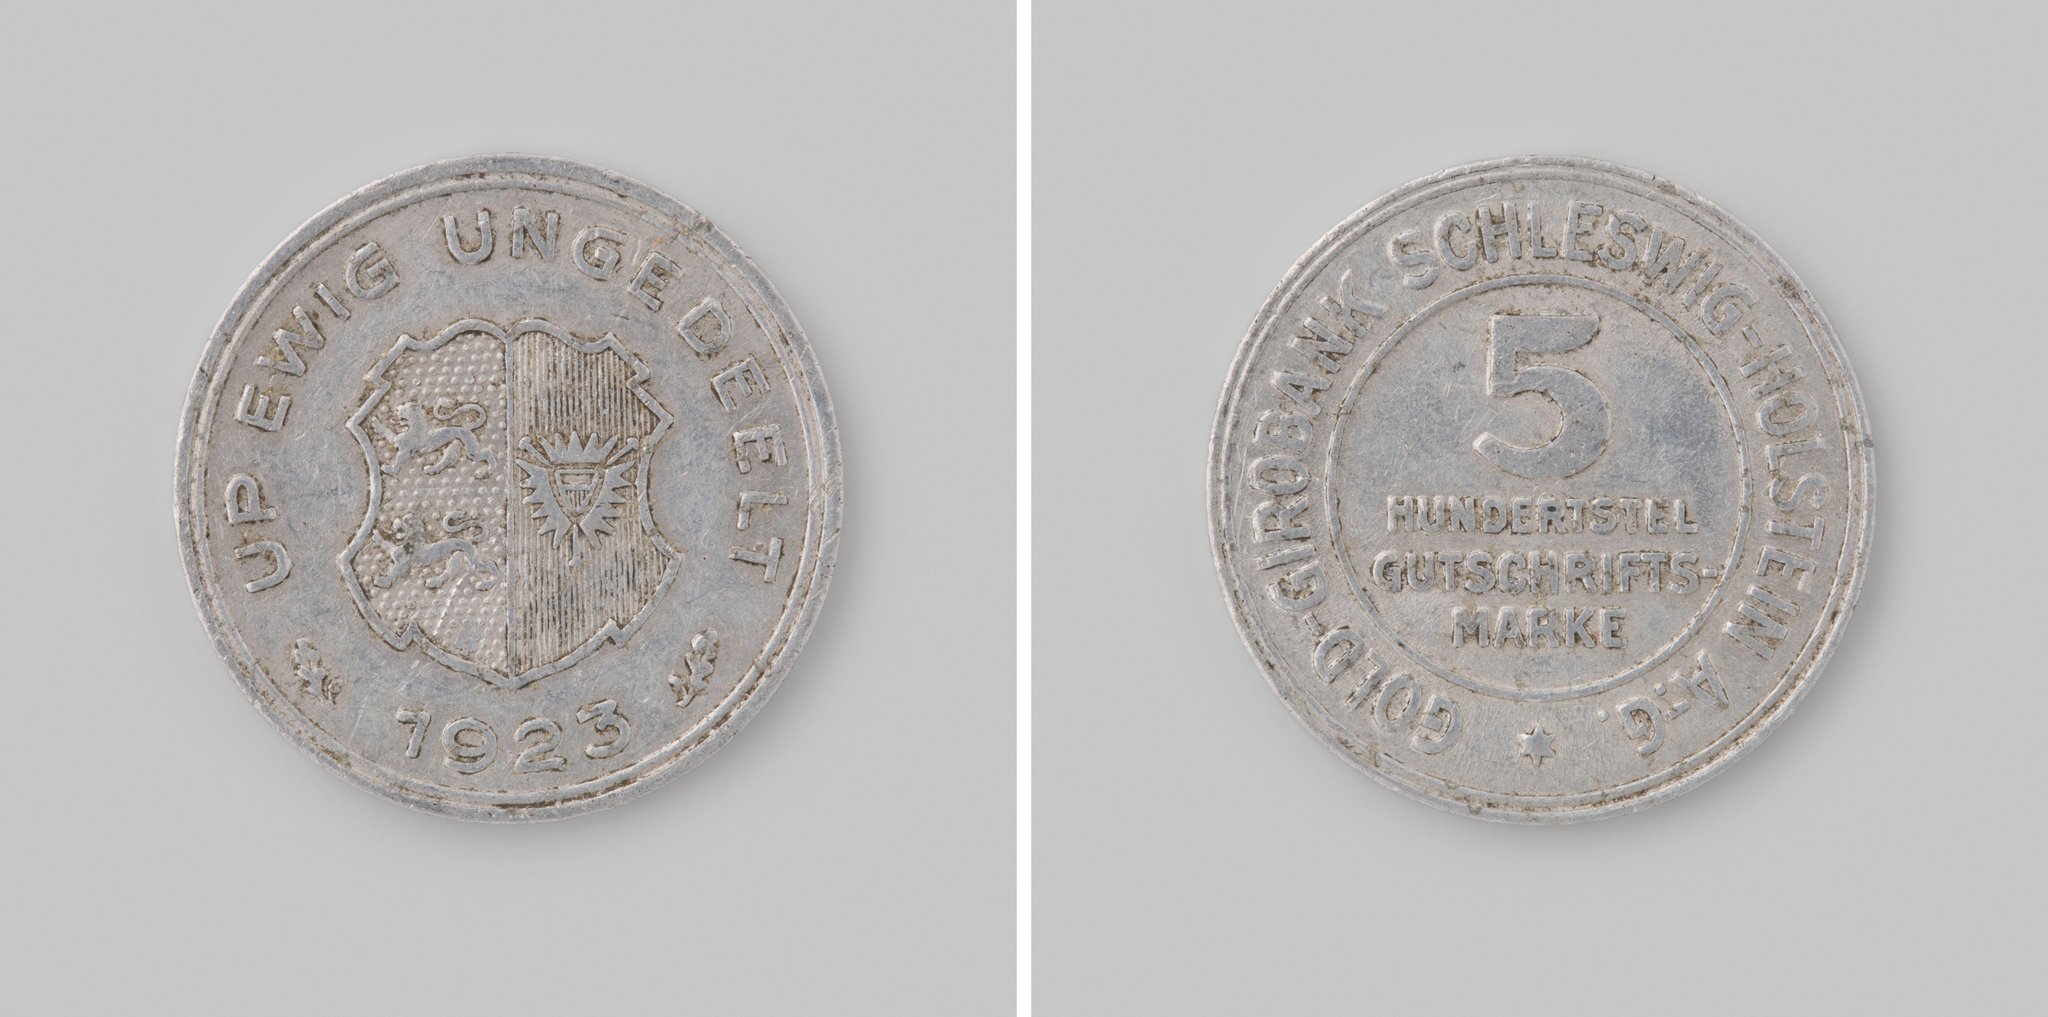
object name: coin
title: Vijf hundertstel gutschriftsmarke uit Duitsland, noodmunt van Sleeswijk-Holstein, 1923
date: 1923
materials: aluminum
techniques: striking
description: Aluminium noodmunt. Voorzijde: wapenschild. Jaartal onderaan. Keerzijde: waarde-aanduiding in vier regels. Aanduiding van de plaatselijke bank. Gladde rand.